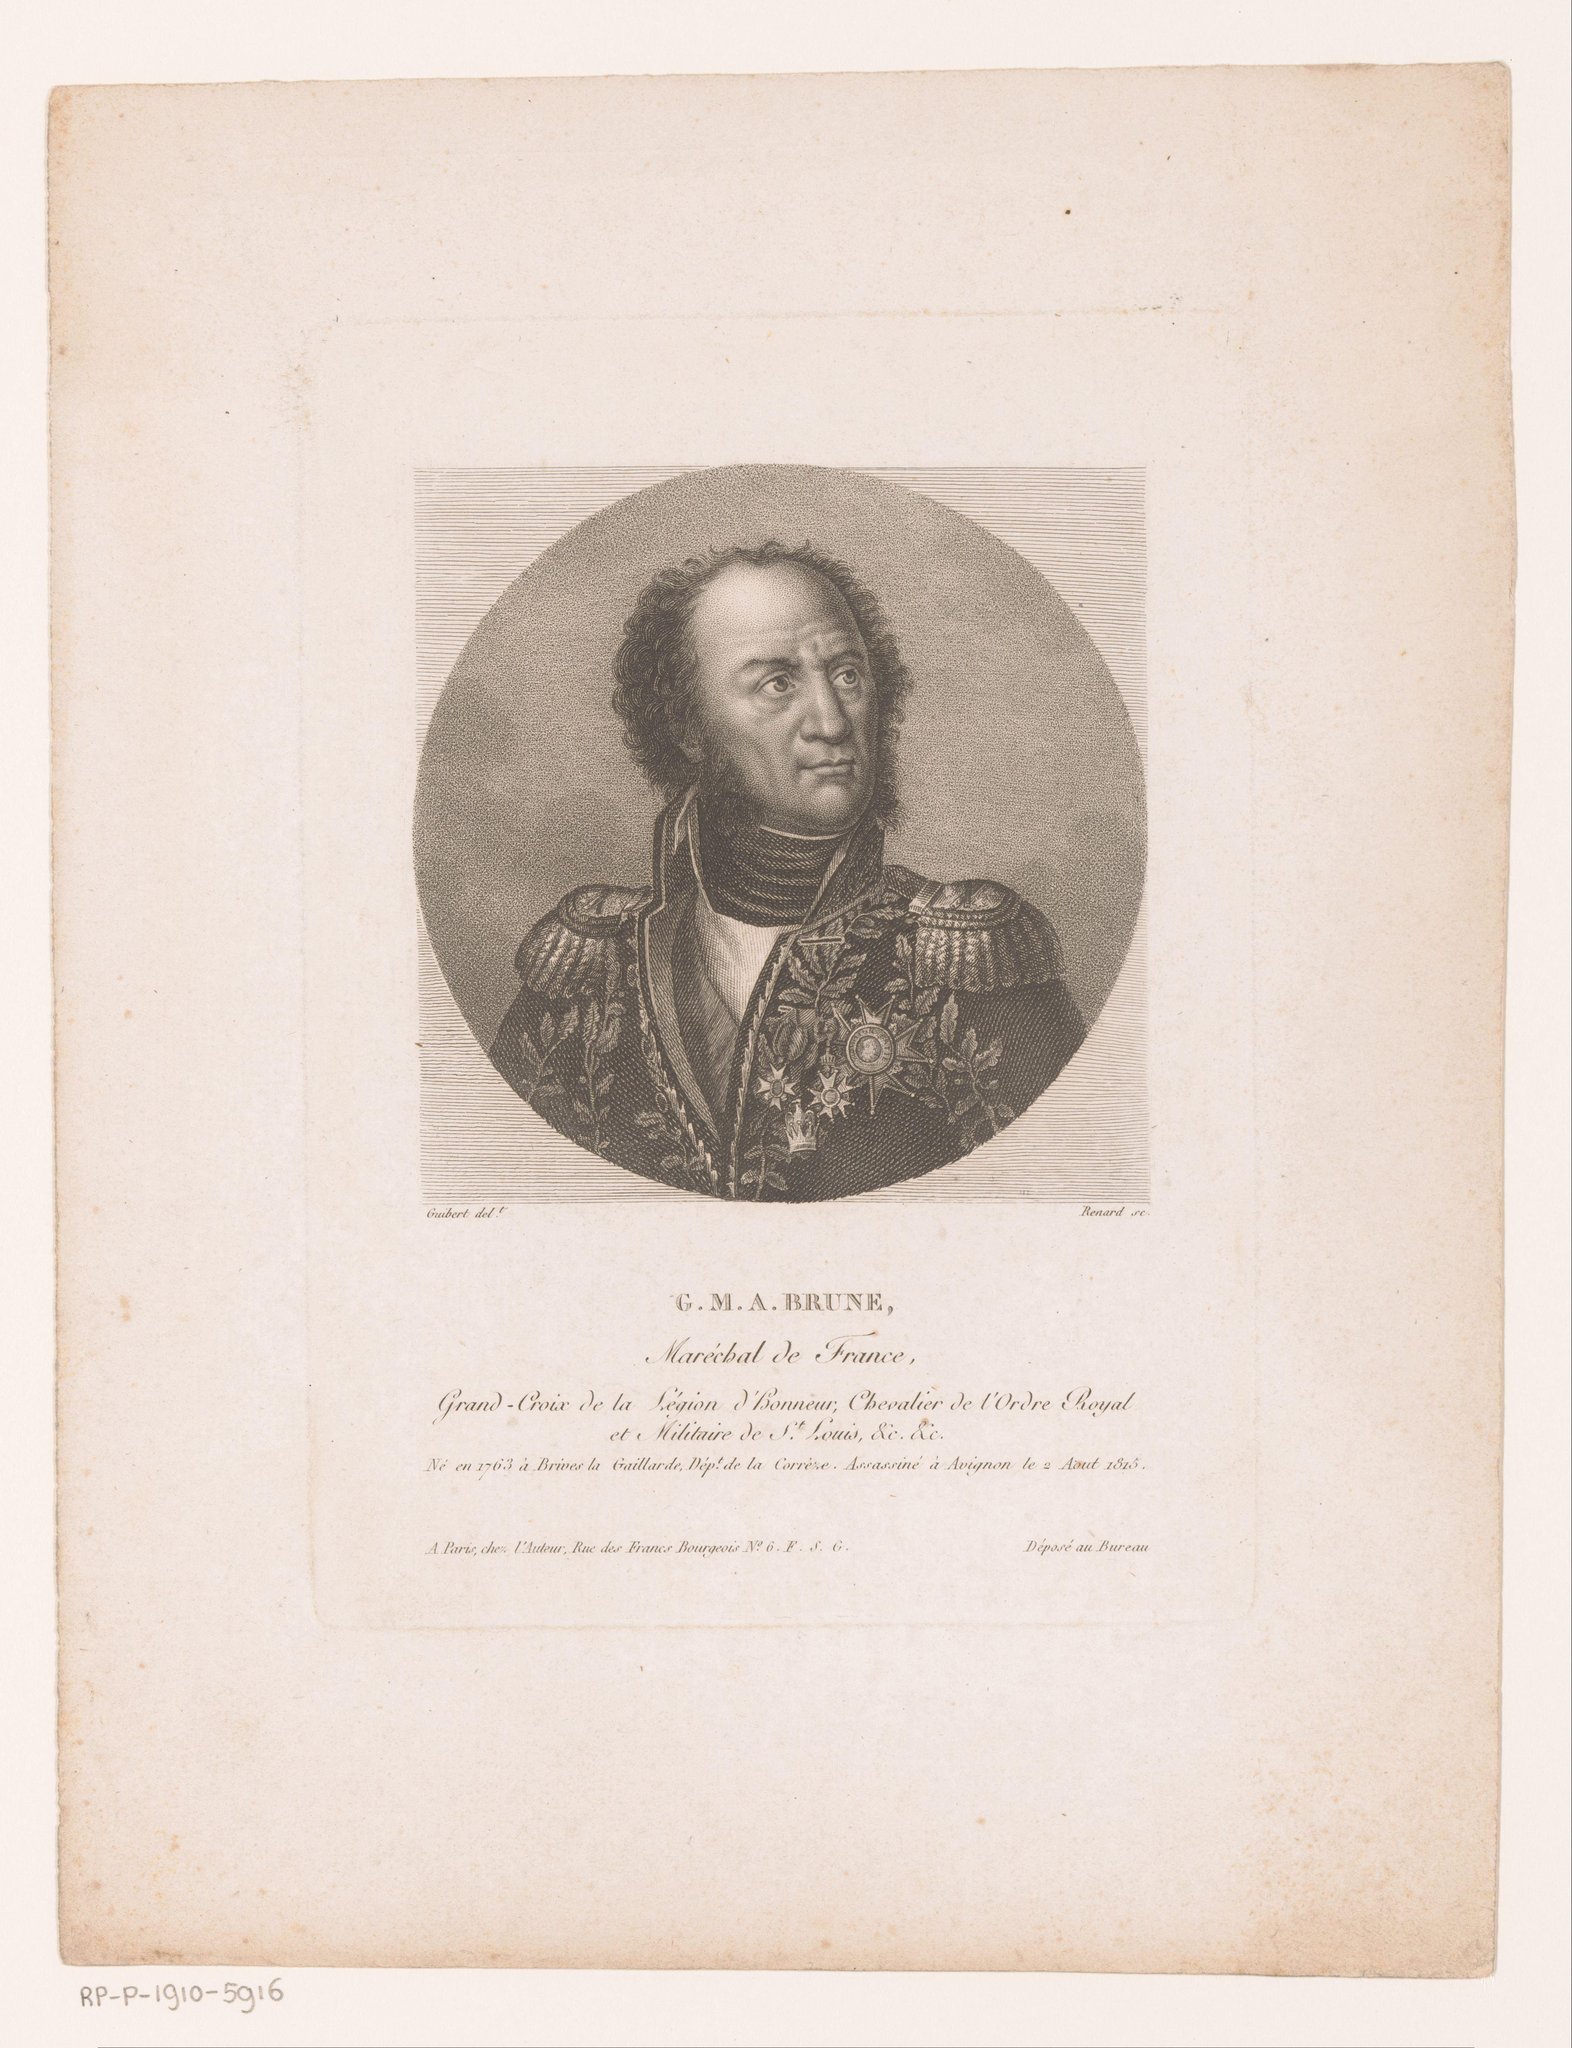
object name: print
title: Portret van Guillaume-Marie-Anne Brune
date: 1782-1814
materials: paper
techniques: etching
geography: paris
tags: commander-in-chief, general, marshal, historical persons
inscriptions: : ‘Déposé au Bureau’, collector's mark: Lugt 2228